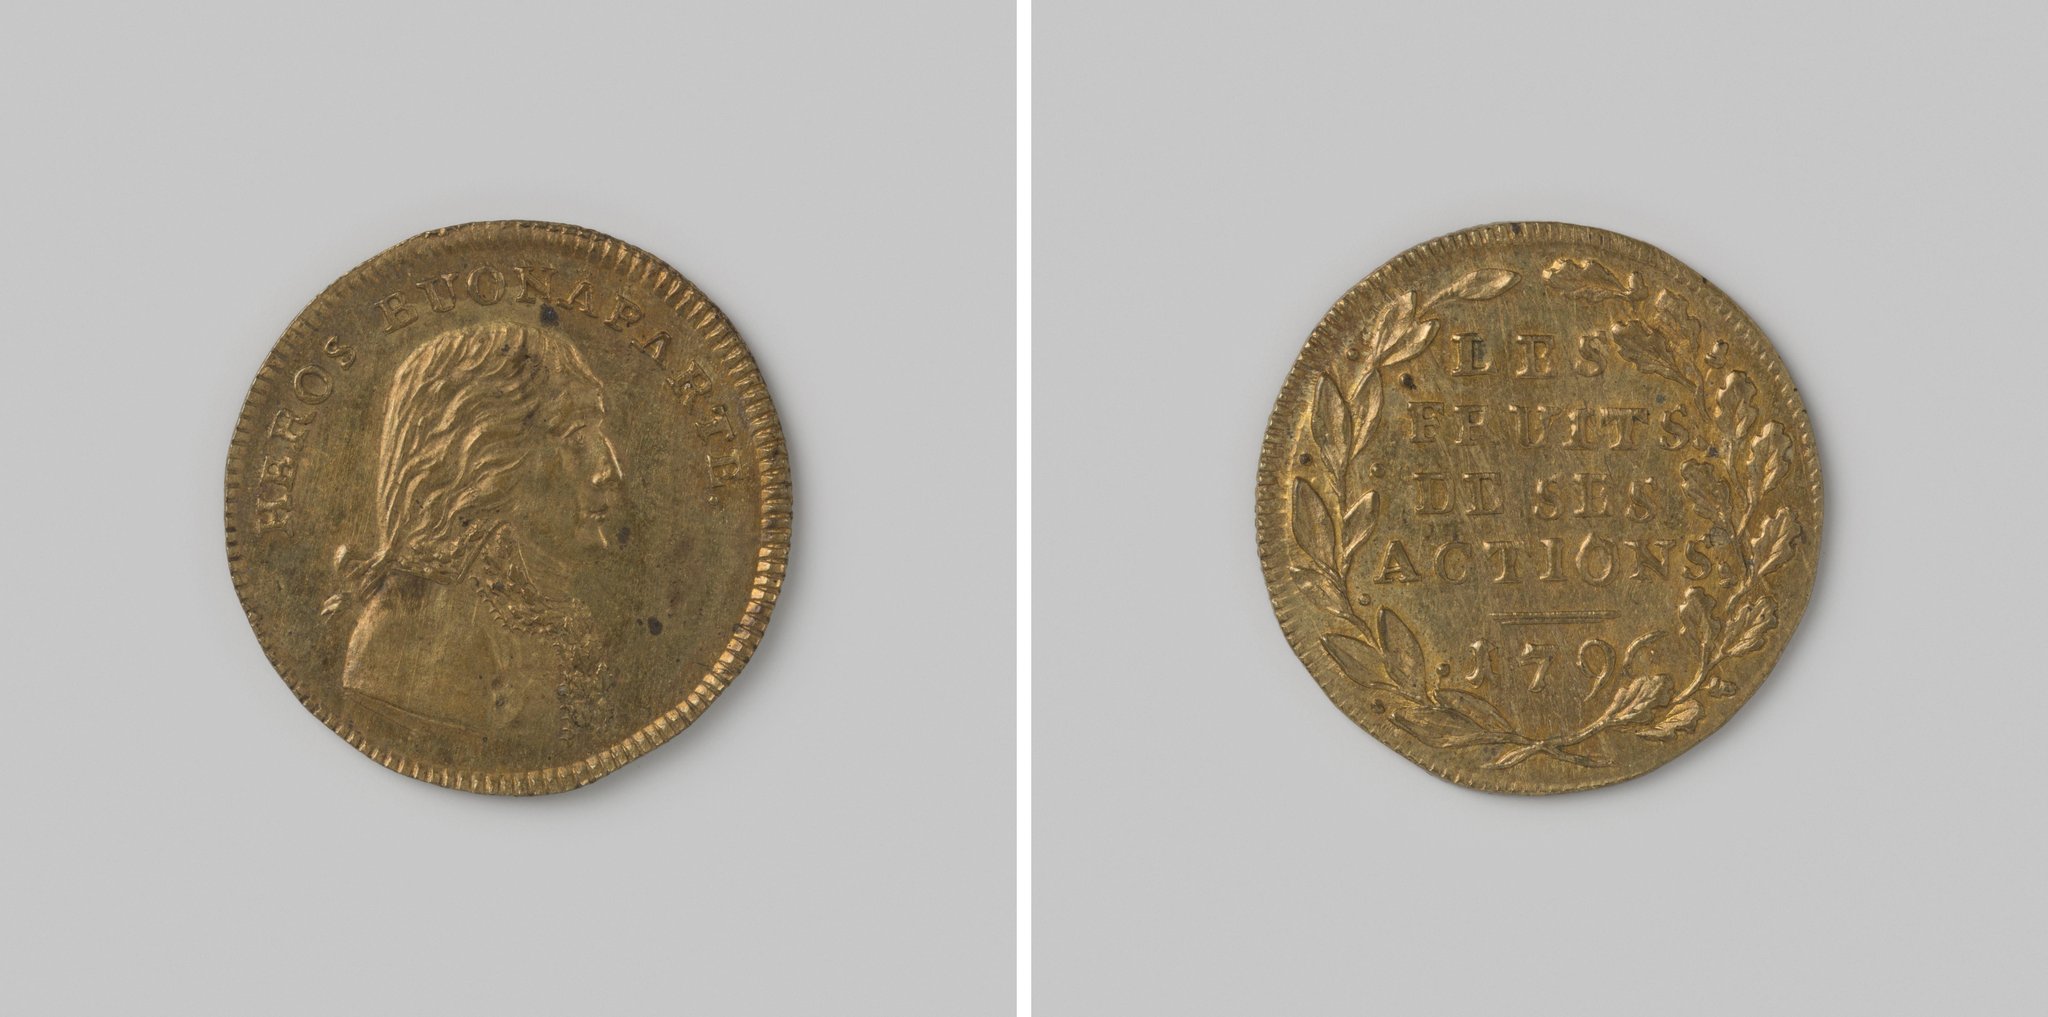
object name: history medal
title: Duitse jeton op de Italiaanse veldtocht van generaal Napoleon Bonaparte 1796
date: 1796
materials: brass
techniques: striking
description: Messing penning, op de voorzijde het borstbeeld van Napoleon naar rechts met omschrift, op de keerzijde vijf regels tekst tussen lauwer- en eikentakken.